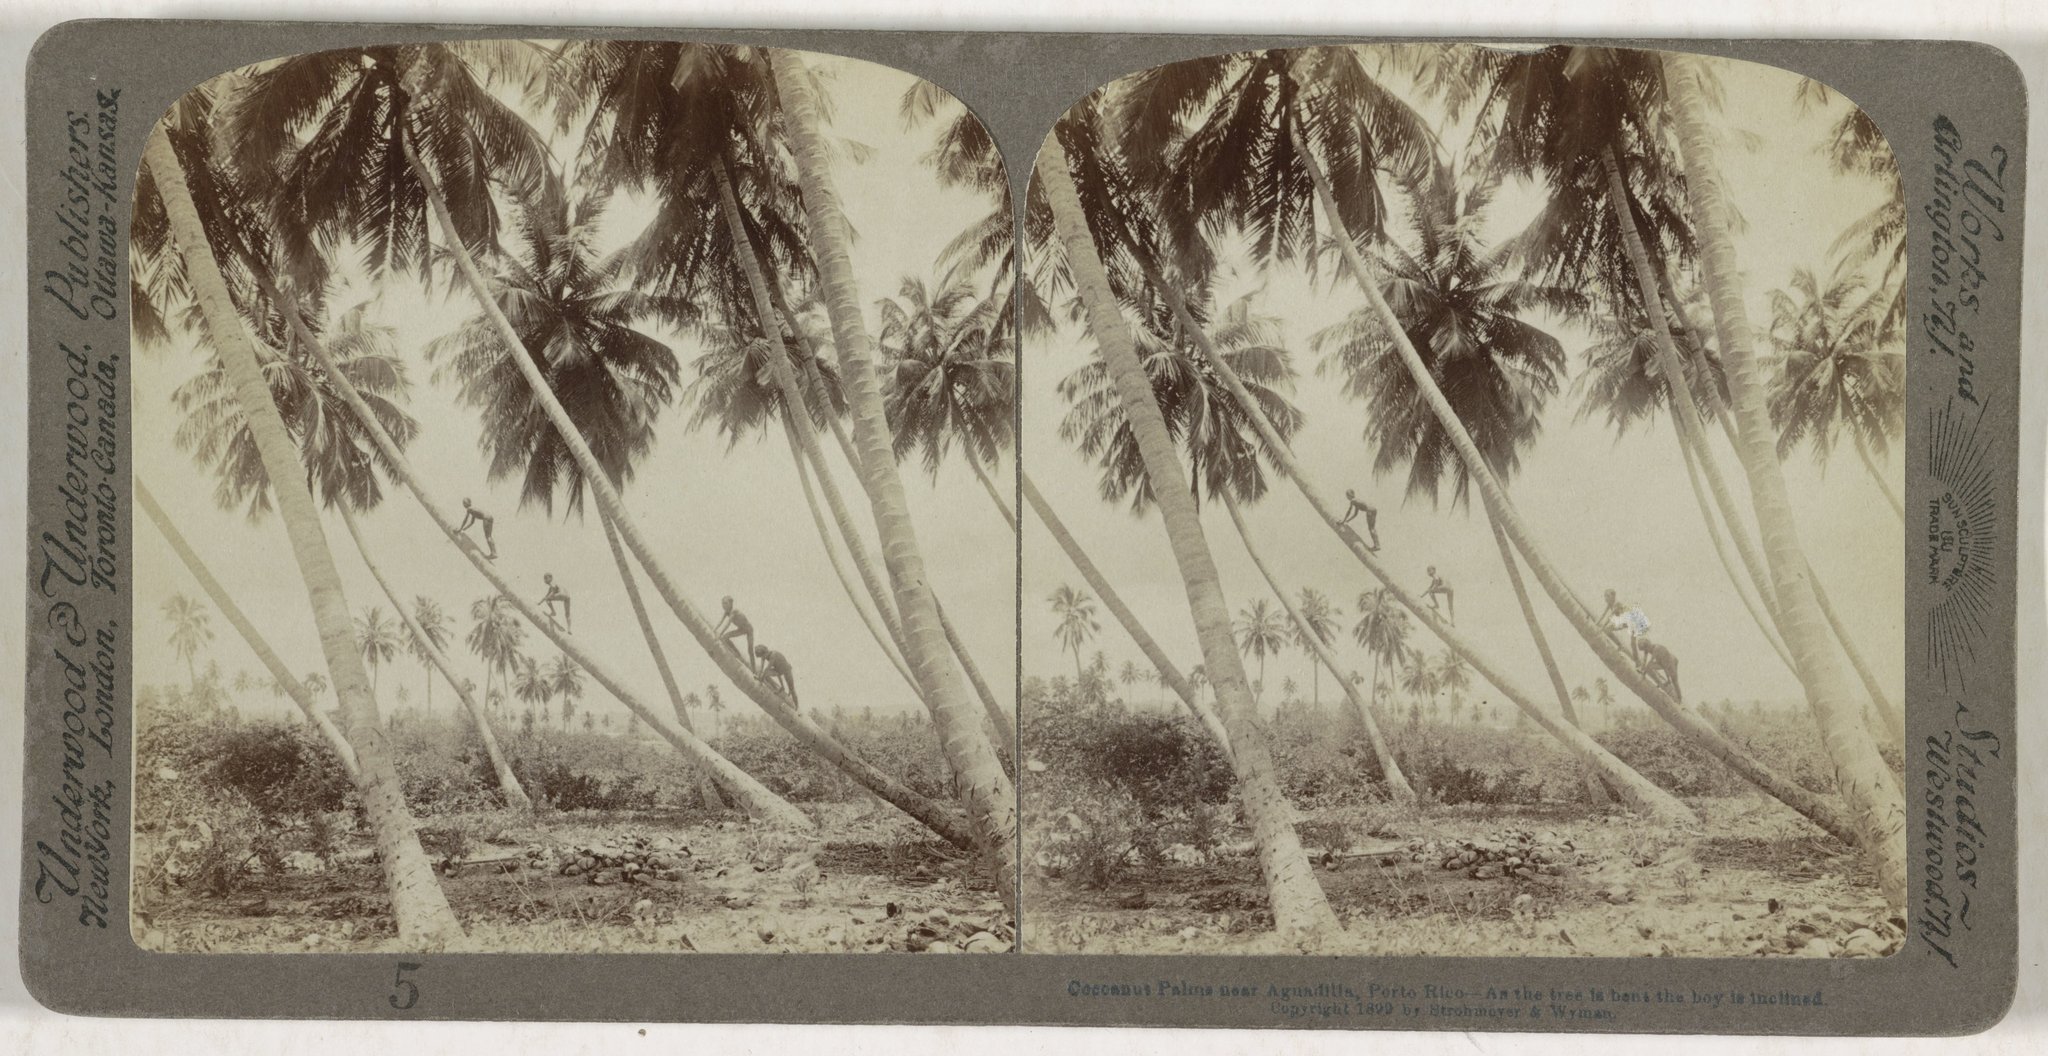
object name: stereograph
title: Cocoanut Palms near Aguadilla, Porto Rico - As the tree is bent the boy is inclined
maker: Anonymous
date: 1899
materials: cardboard, paper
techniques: albumen print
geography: new york city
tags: trees: coconut-tree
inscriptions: number: ‘5’, check stamp: ‘(ENERET)’, number: ‘N 12.’, title: ‘Cocoanut Palms near Aguadilla, Porto Rico - As the tree is bent the boy is inclined.’, copyright notice: ‘Copyright 1899 by Strohmeyer & Wyman.’, inscription: ‘SUN SCULPTURE/ UU/ TRADEMARK/ Works and Studios/ Arlington, N.J. Westwood, N.J. Washington, D.C.’